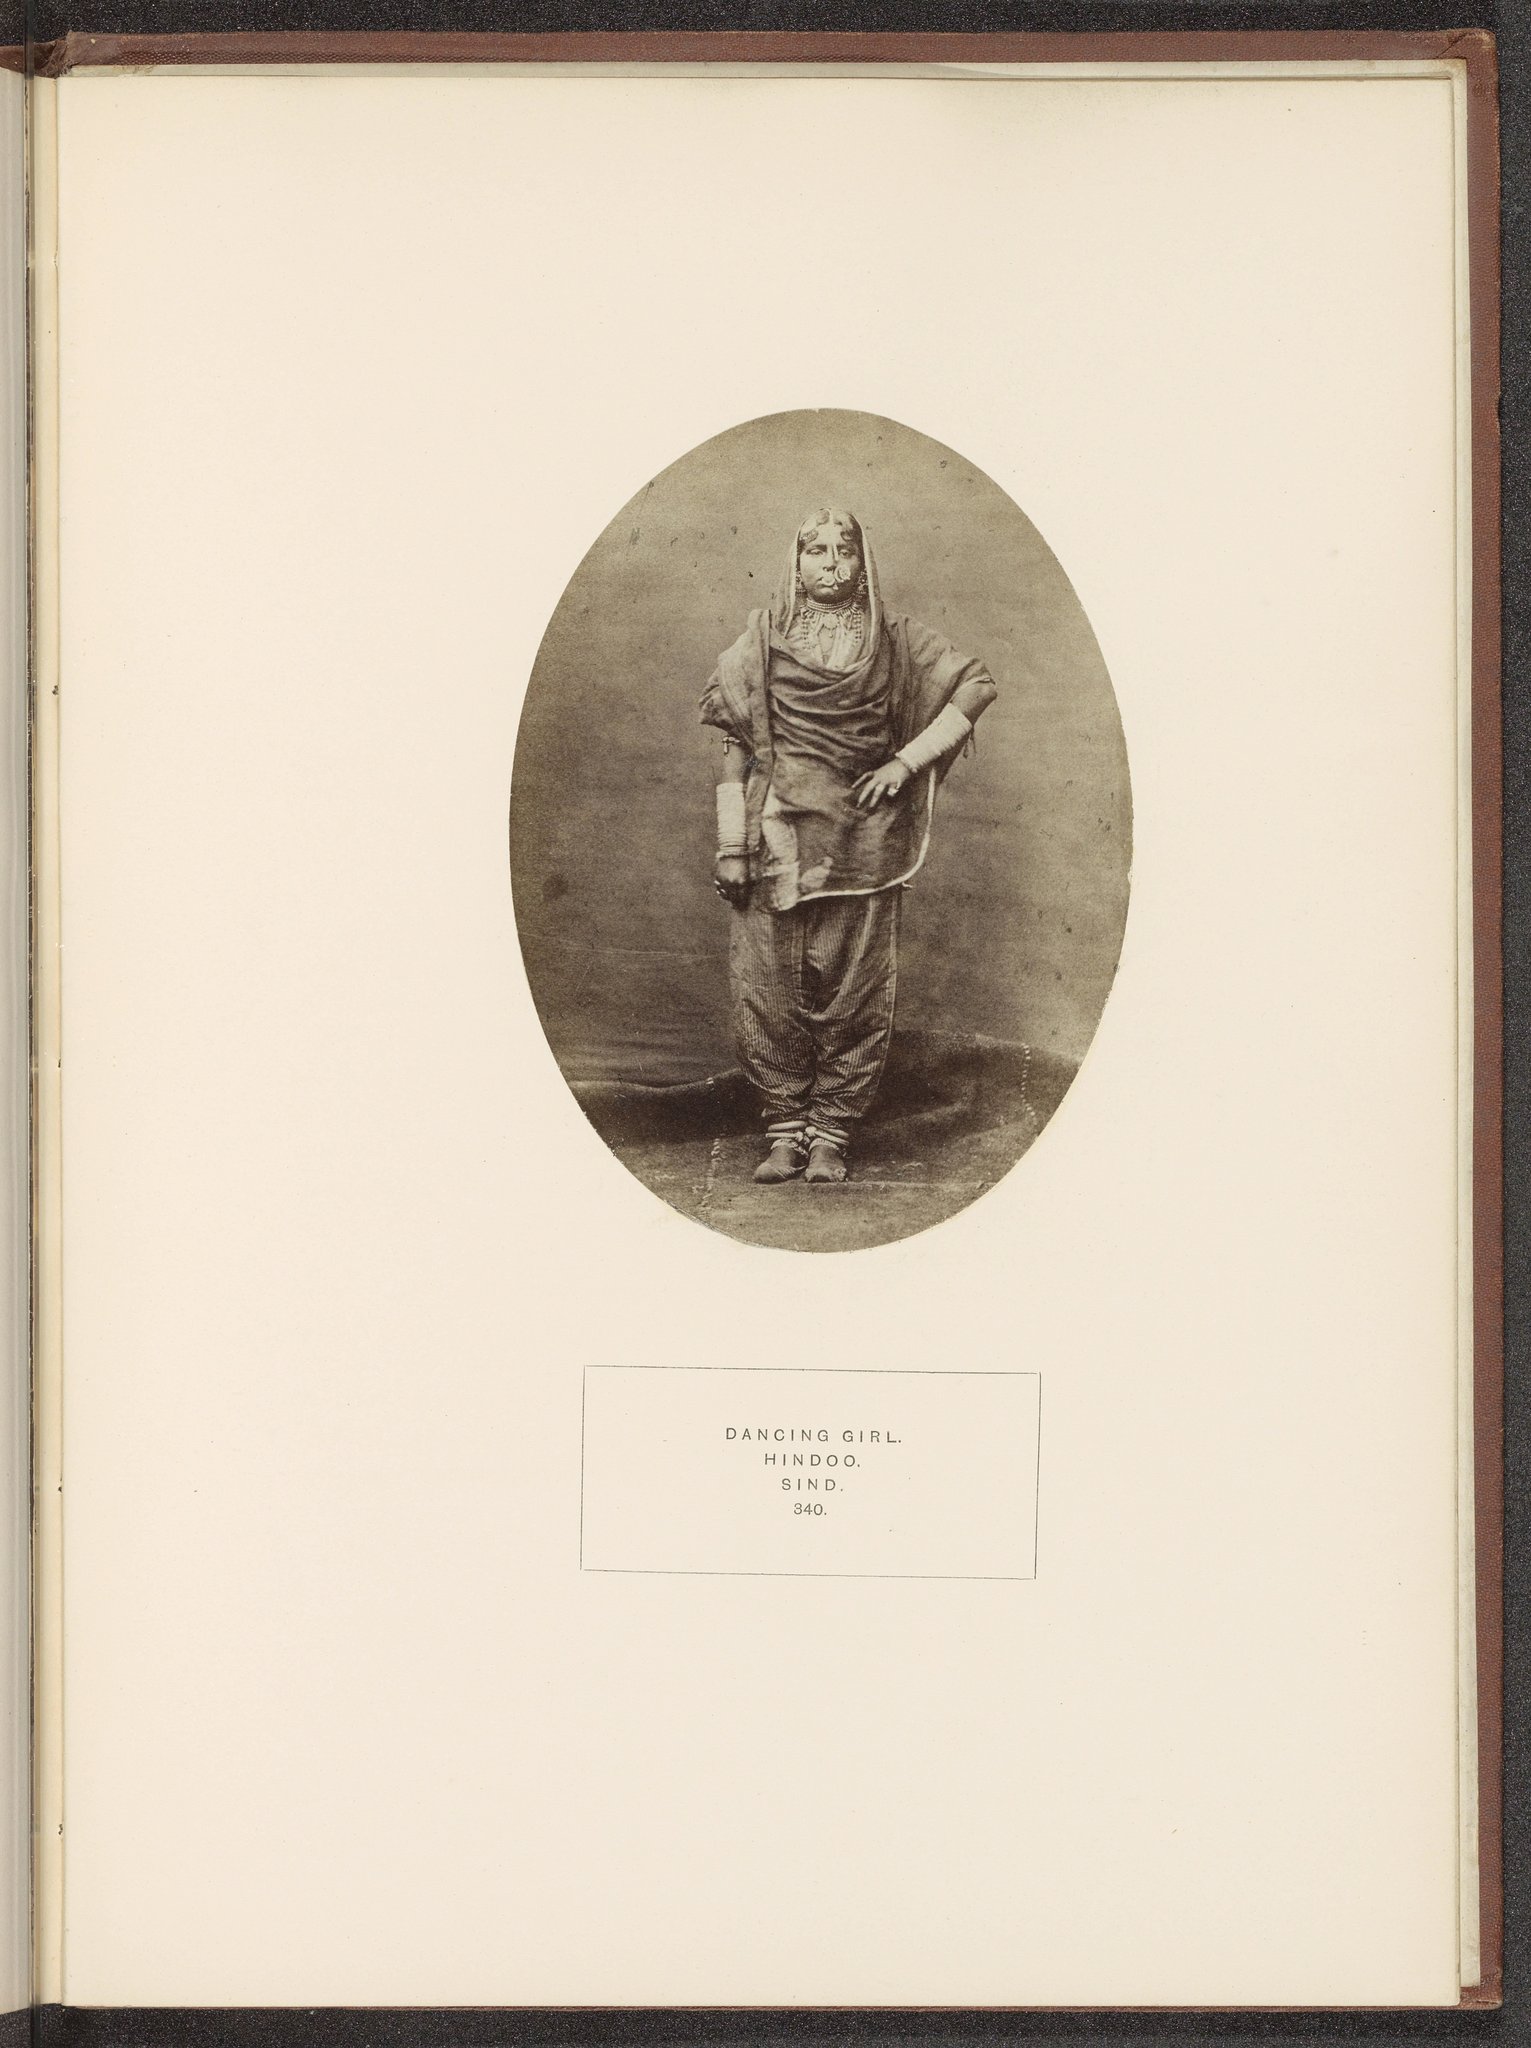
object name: photograph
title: Portrait of an unknown female dancer in Sindh, Pakistan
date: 1862-1872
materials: photographic support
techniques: albumen print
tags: head-gear (with name), female dancer, human races; peoples; nationalities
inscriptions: number: ‘340.’, inscription: ‘DANCING GIRL./ HINDOO./ SIND.’